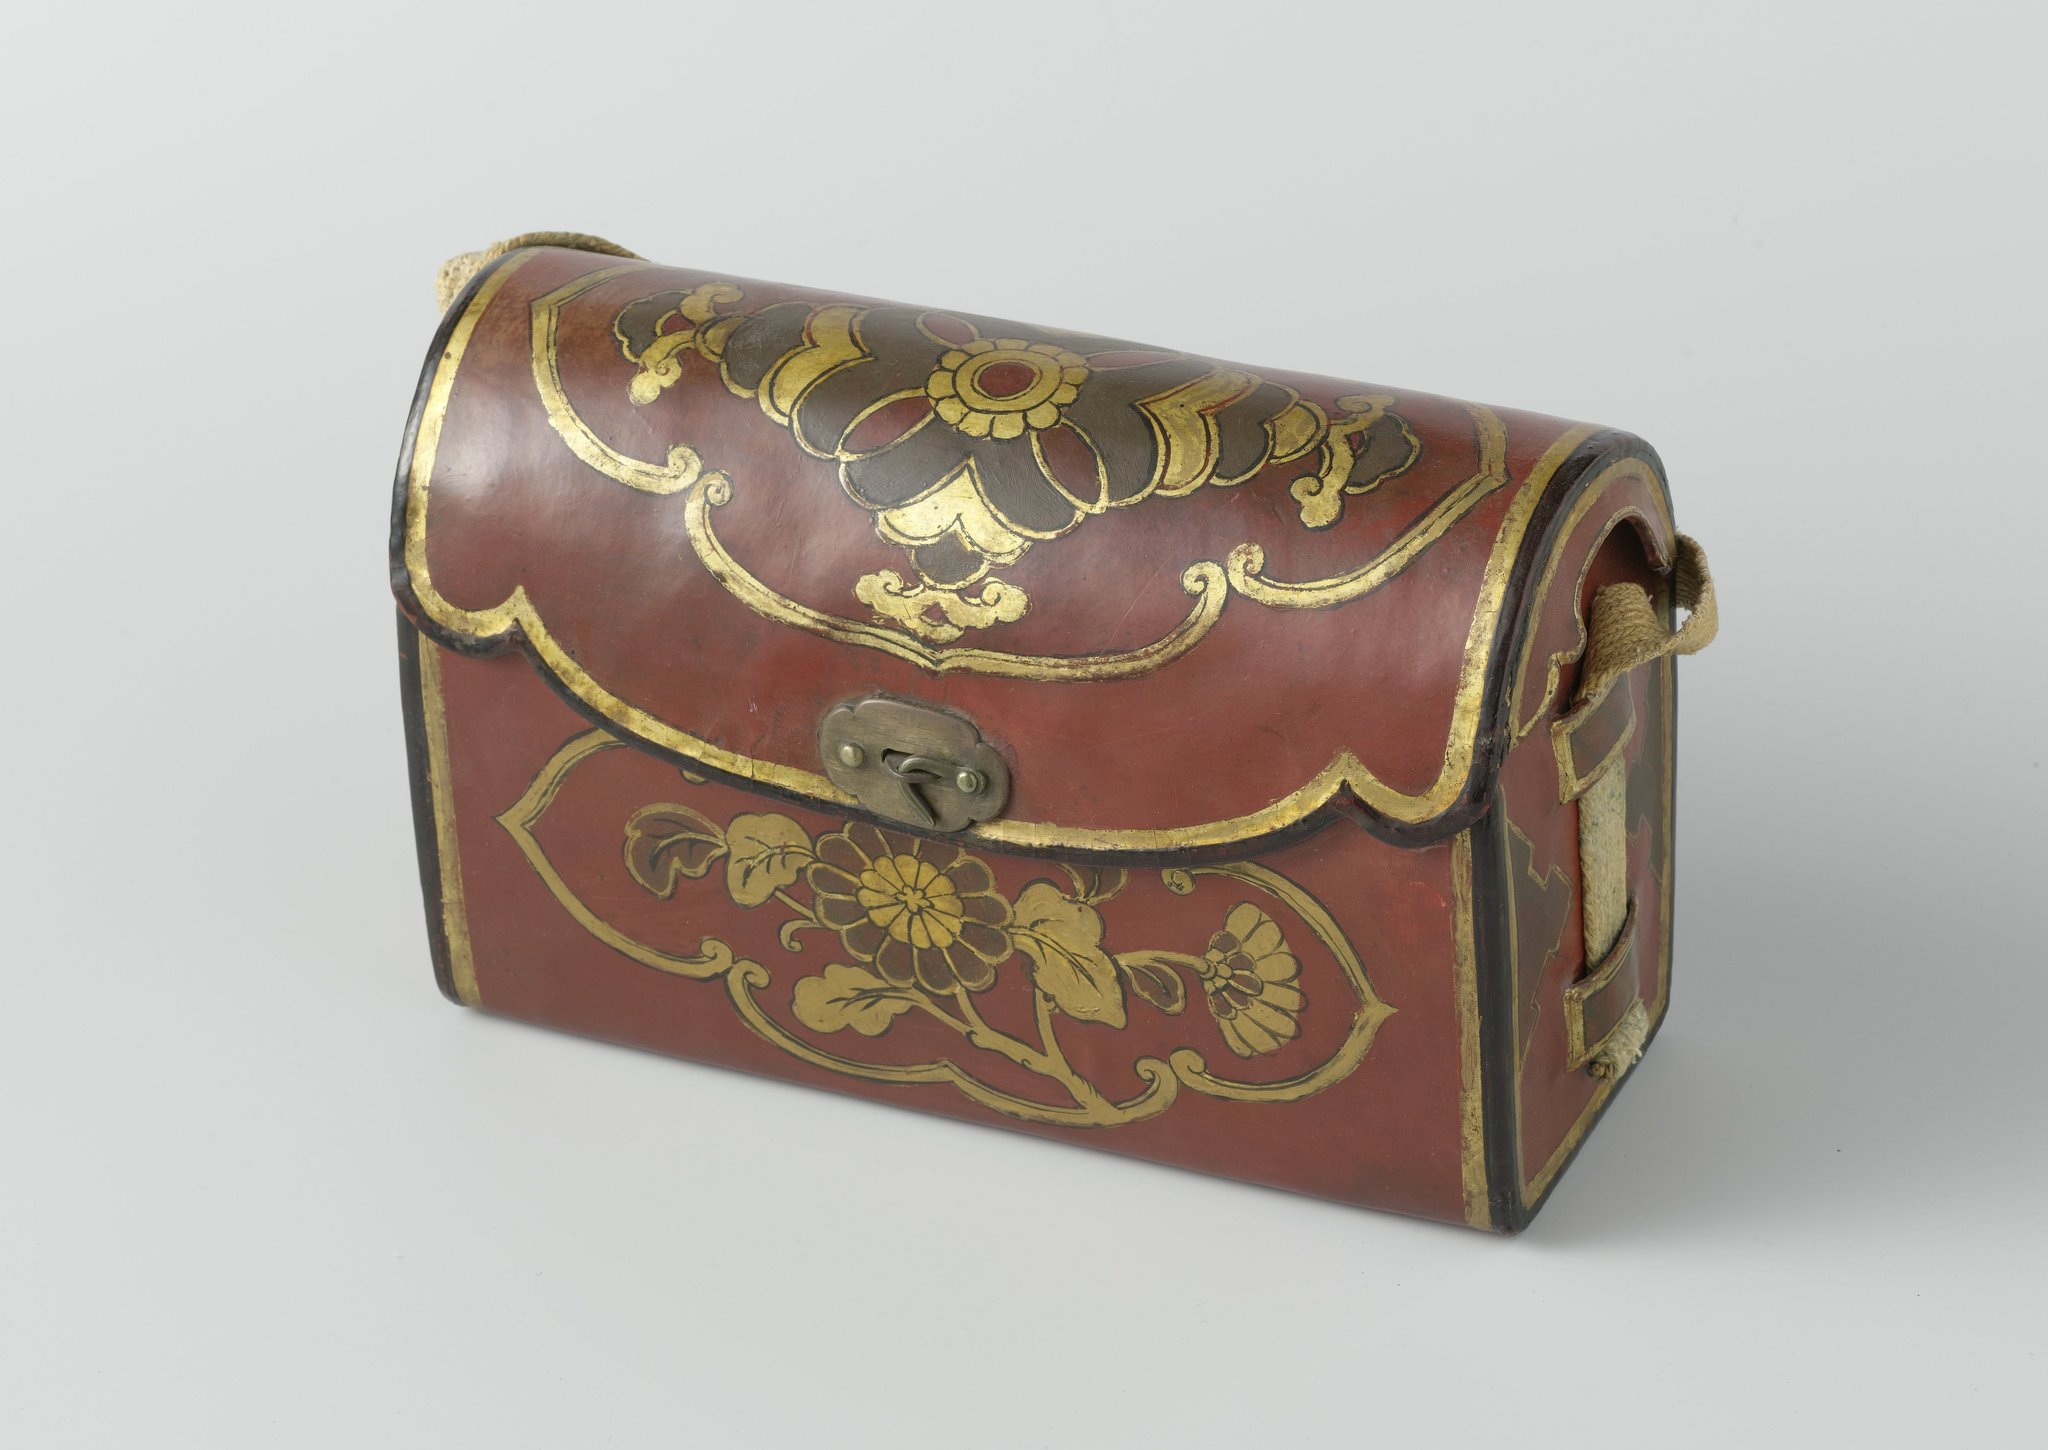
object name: cartridge pouch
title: Patroontas behorend bij wapenrek van Cornelis Tromp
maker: Anonymous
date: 1650-1679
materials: brass, cotton, lacquer, leather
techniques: gilding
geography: southeast asia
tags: rotterdam, amsterdam, cornelis tromp, flowers ~ ornament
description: Arms collection of Cornelis Tromp. These weapons were kept at the Amsterdam home of Cornelis Tromp. The collection included contemporary weapons of exceptional quality and several exotic weapons acquired for their curiosity value. Tromp probably received many of these weapons as gifts during his patrols of the Mediterranean Sea and in the Baltic.